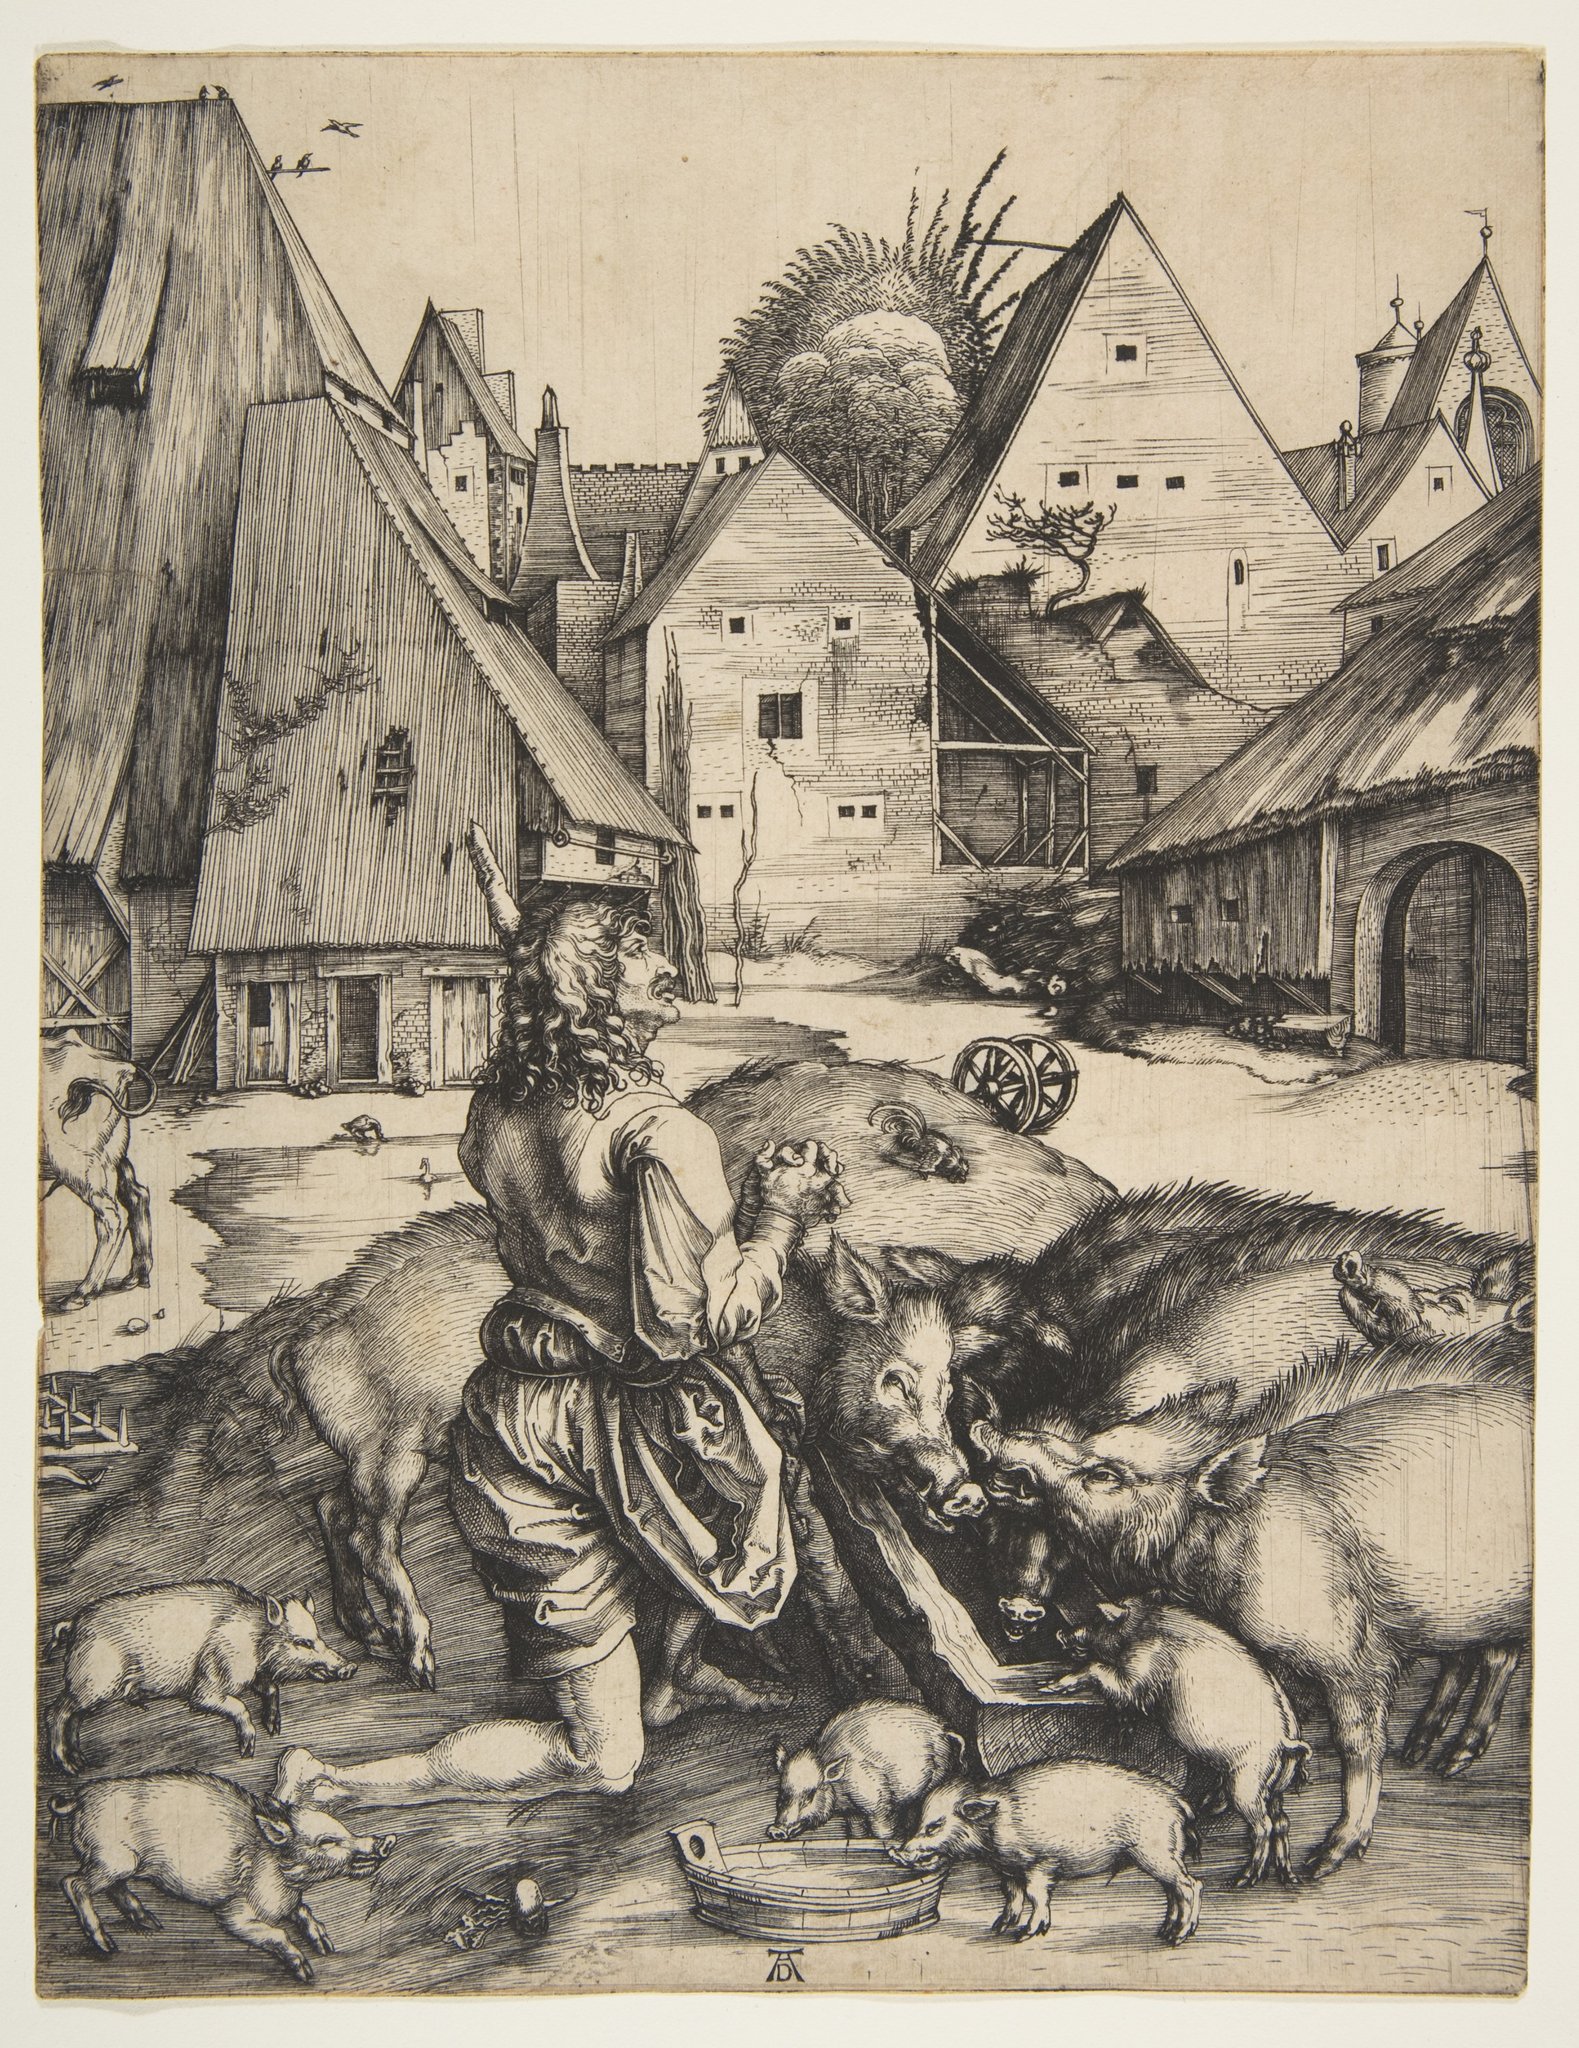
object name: print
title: The Prodigal Son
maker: albrecht dürer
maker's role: artist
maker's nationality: german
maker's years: 1471-1528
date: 1496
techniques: engraving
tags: houses,men,pigs